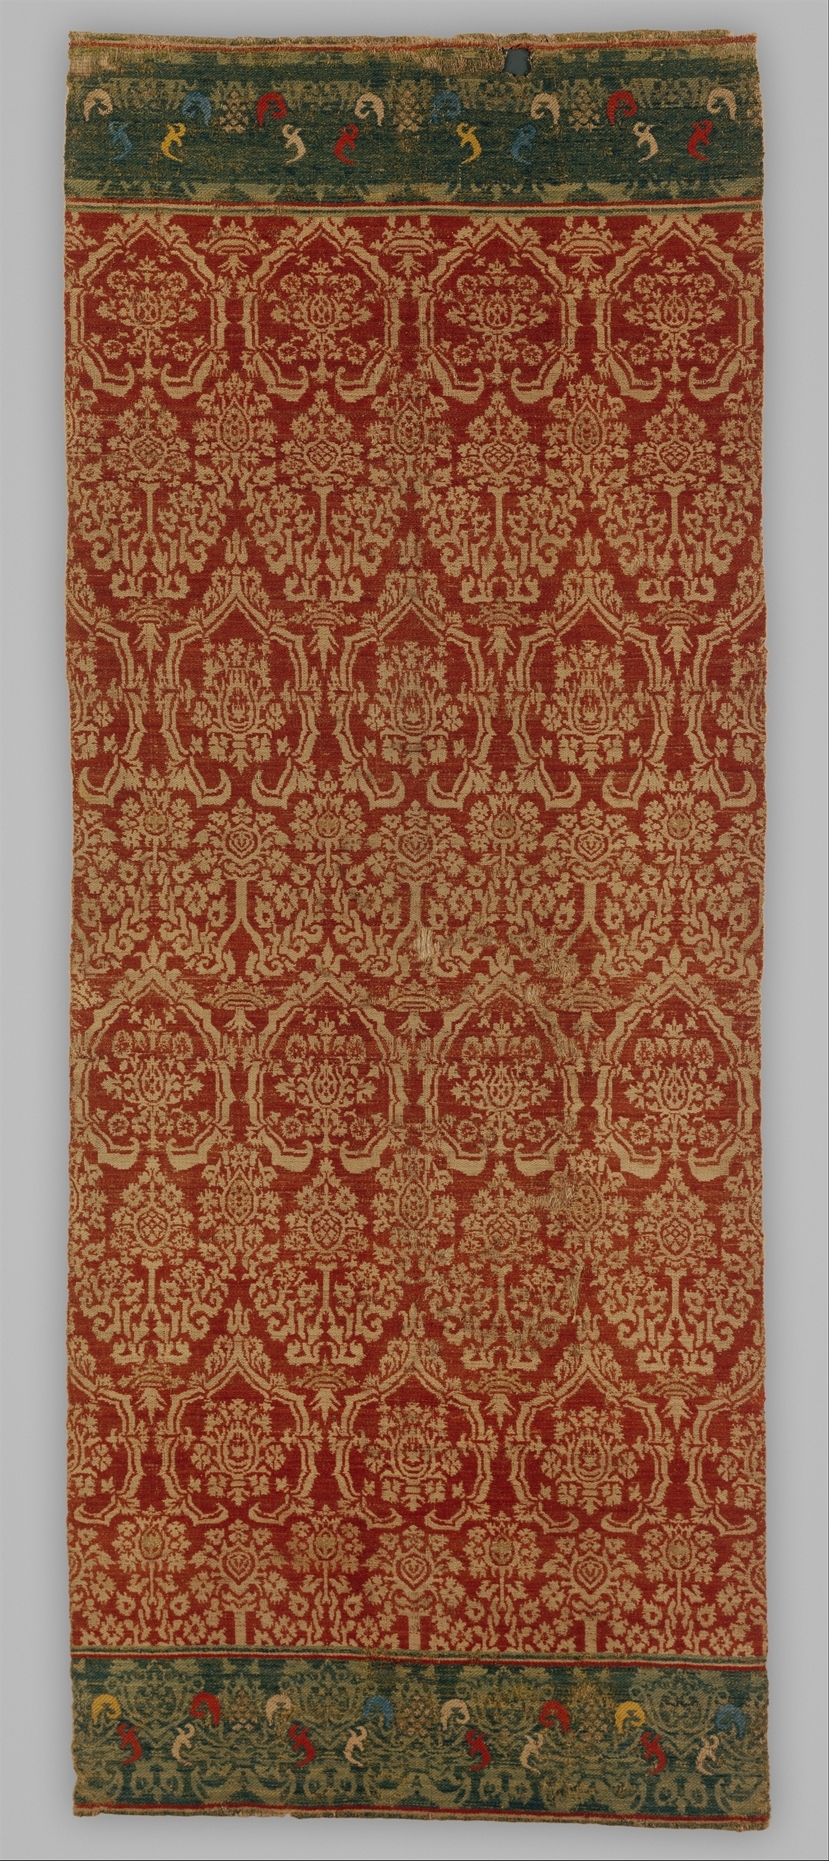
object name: hanging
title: Wall Hanging, with Pomegranate Pattern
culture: german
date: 1501-1533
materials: linen, metal thread, wool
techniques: brocade, weave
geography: nuremberg